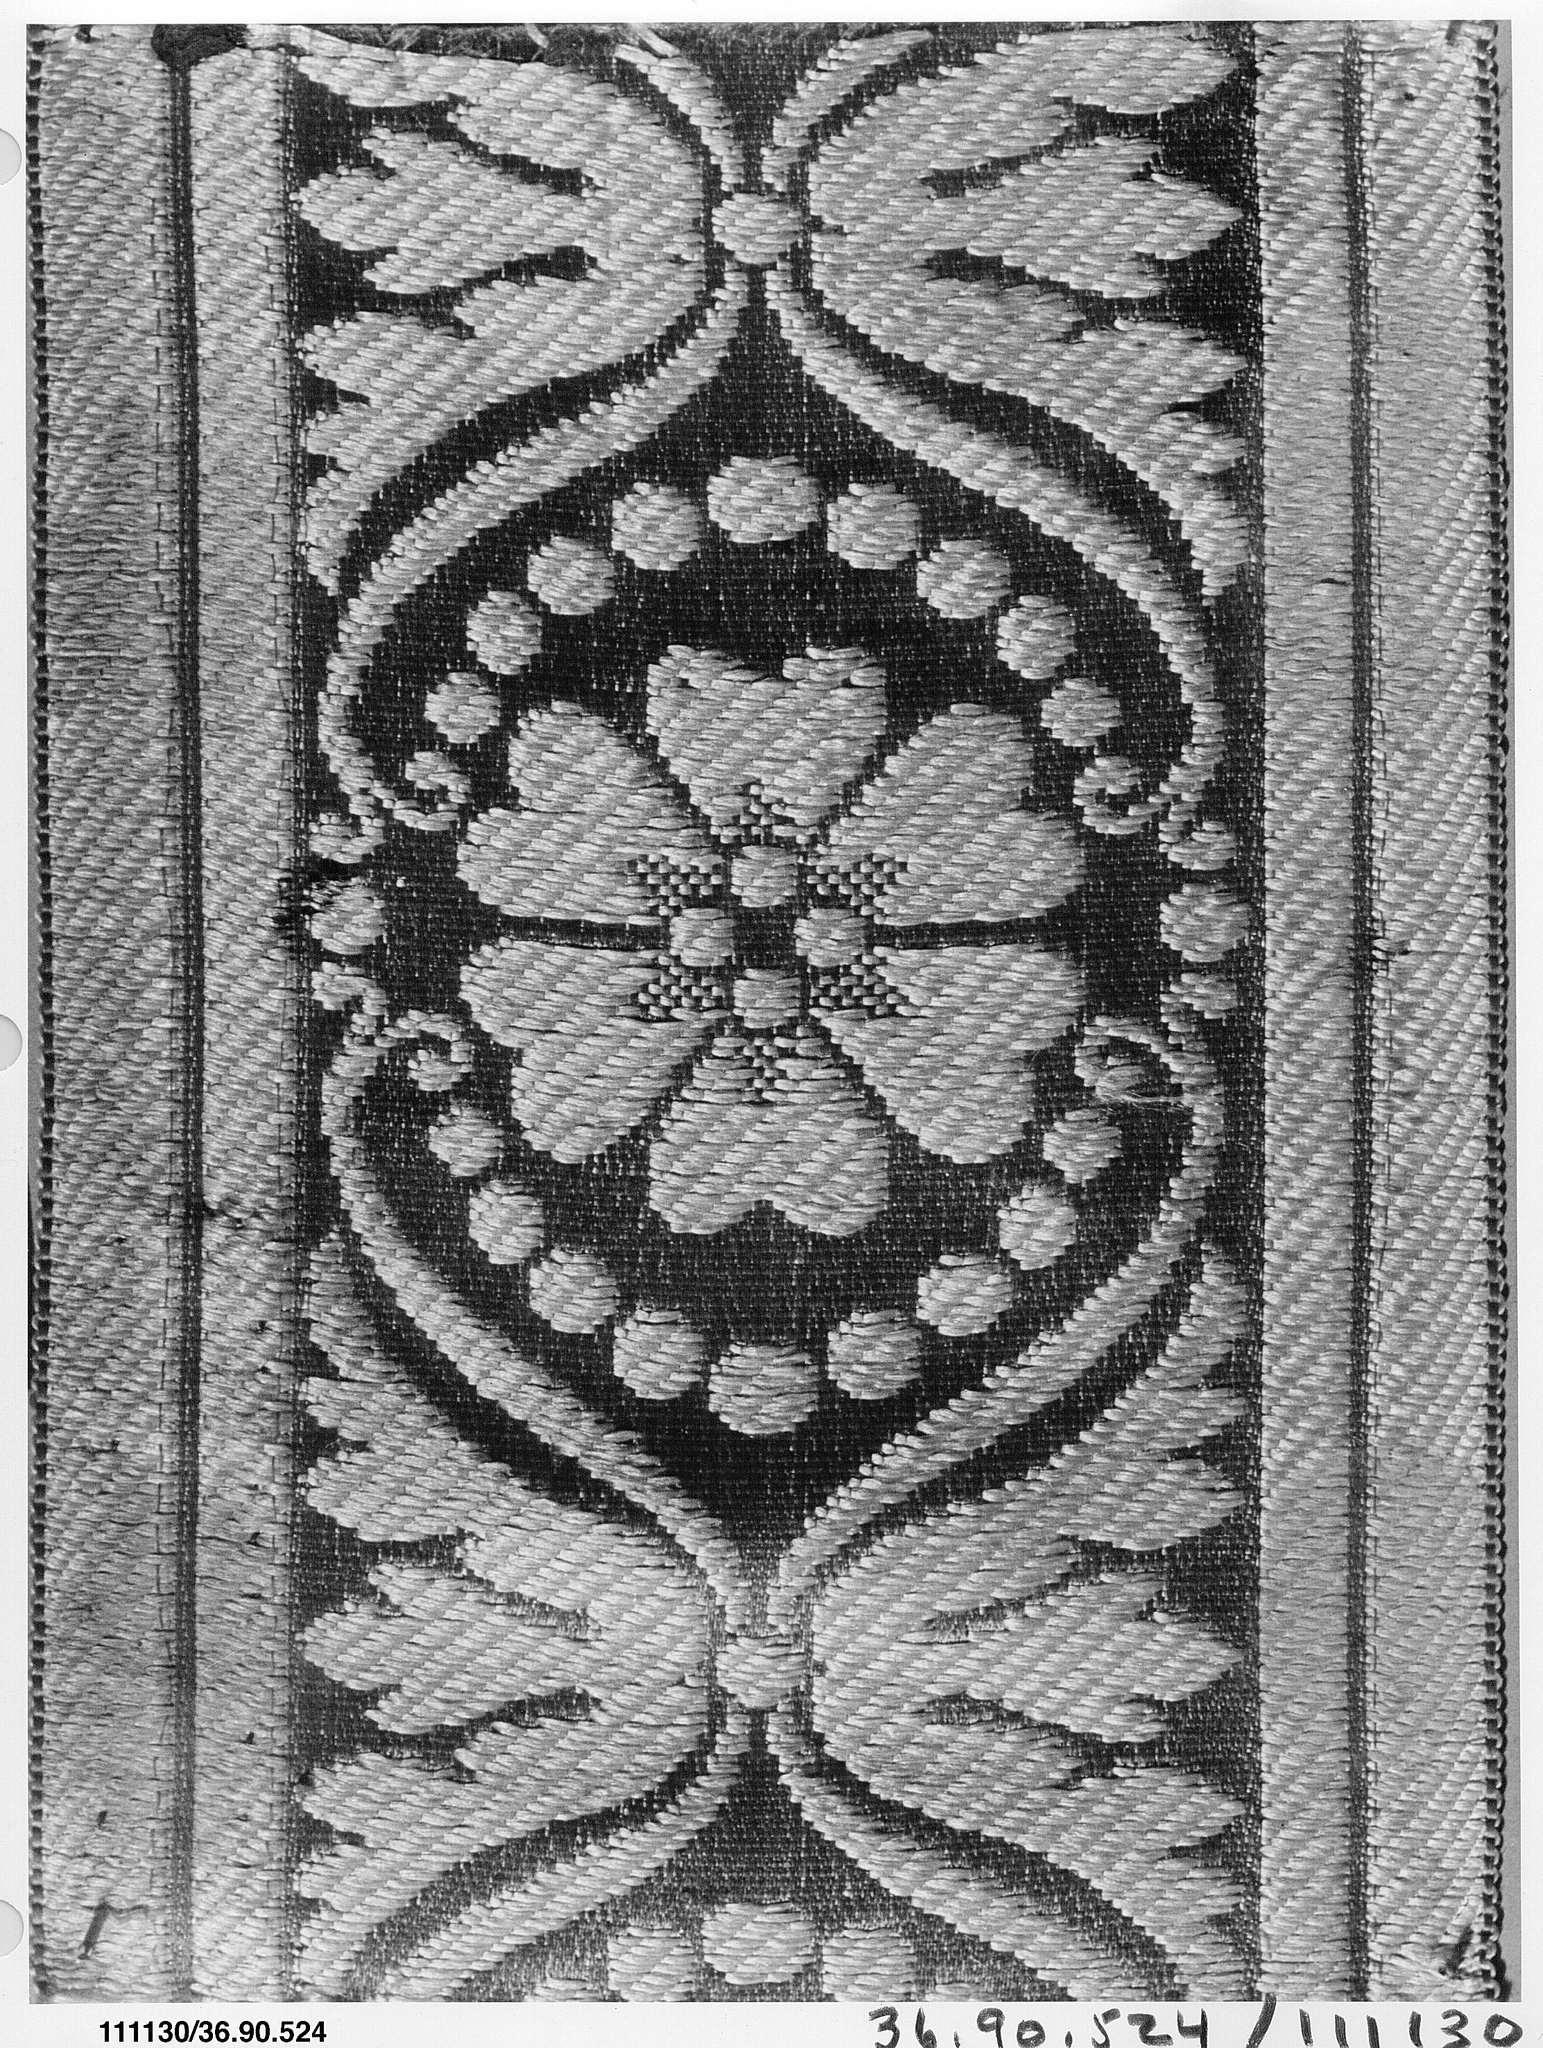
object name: piece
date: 1801-1833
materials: silk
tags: flowers